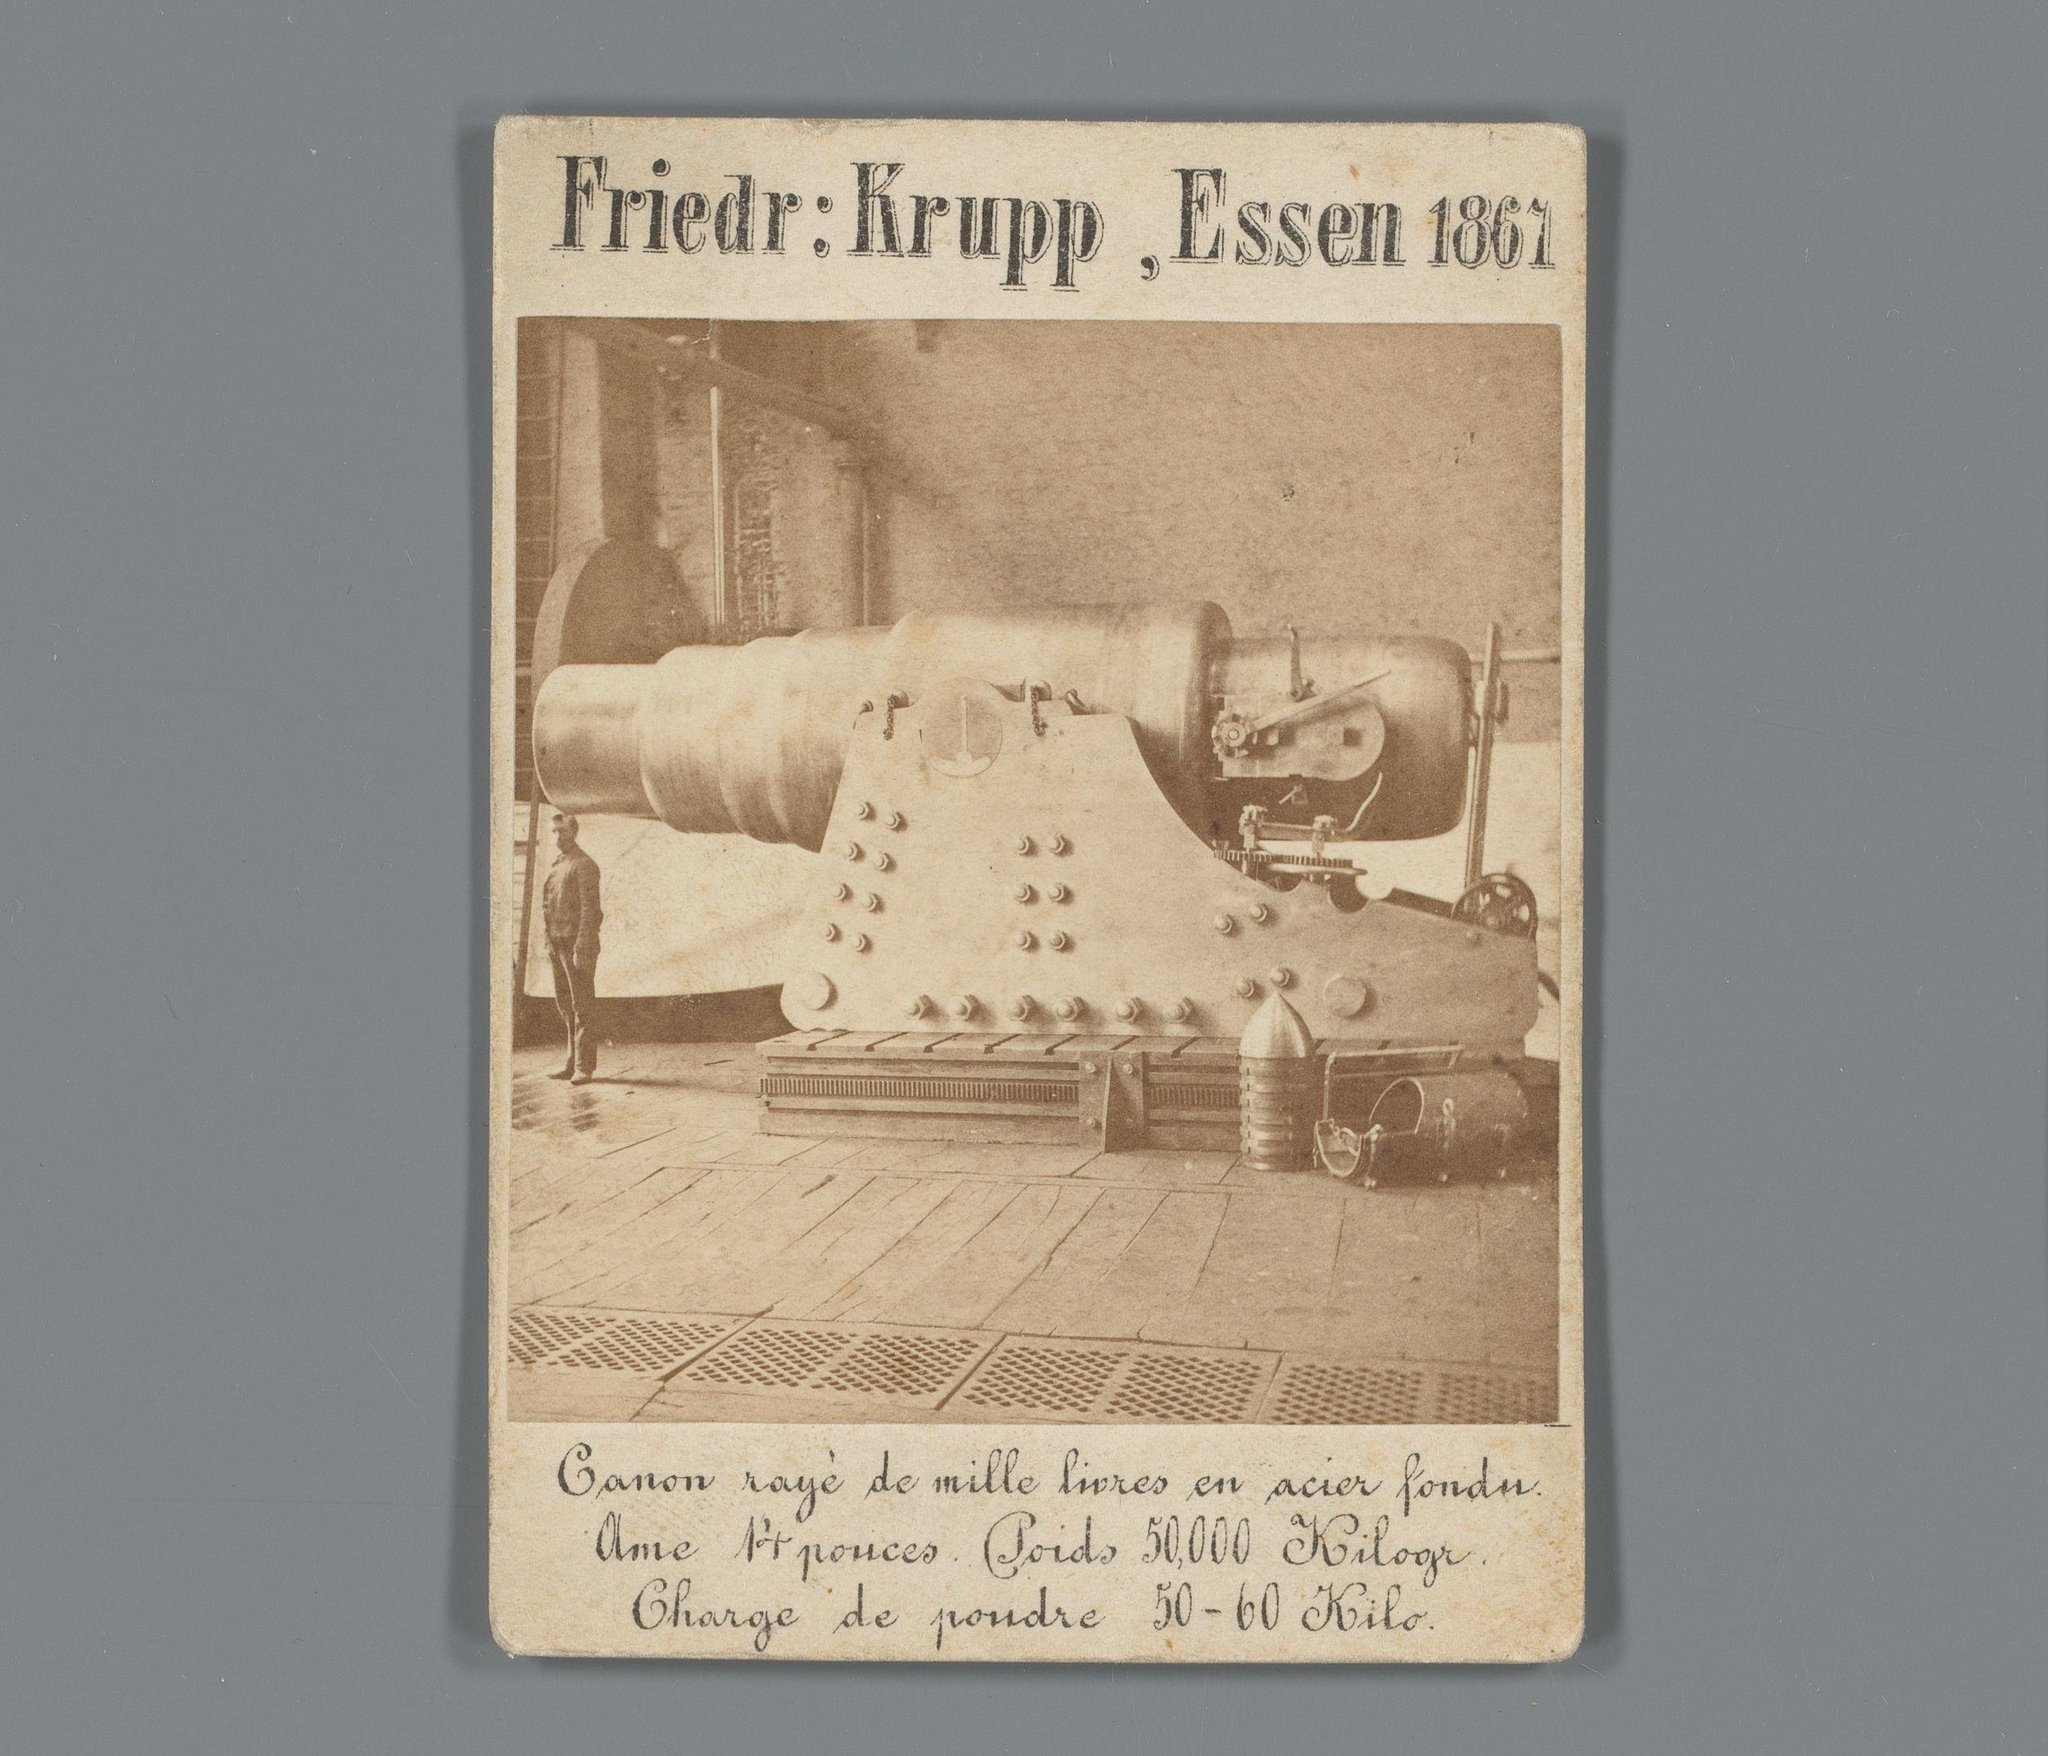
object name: photograph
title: Reclame voor een kanon vervaardigd door Friedrich Krupp uit Essen, Duitsland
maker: Anonymous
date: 1867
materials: cardboard, photographic support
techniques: albumen print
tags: advertising, weapons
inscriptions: inscription: ‘Friedr: Krupp, Essen 1867/ Canon rayé de mille livres en acier fondu/ (...)’, inscription: ‘Krupp [...]/ Paris[...] 1867 [...]’